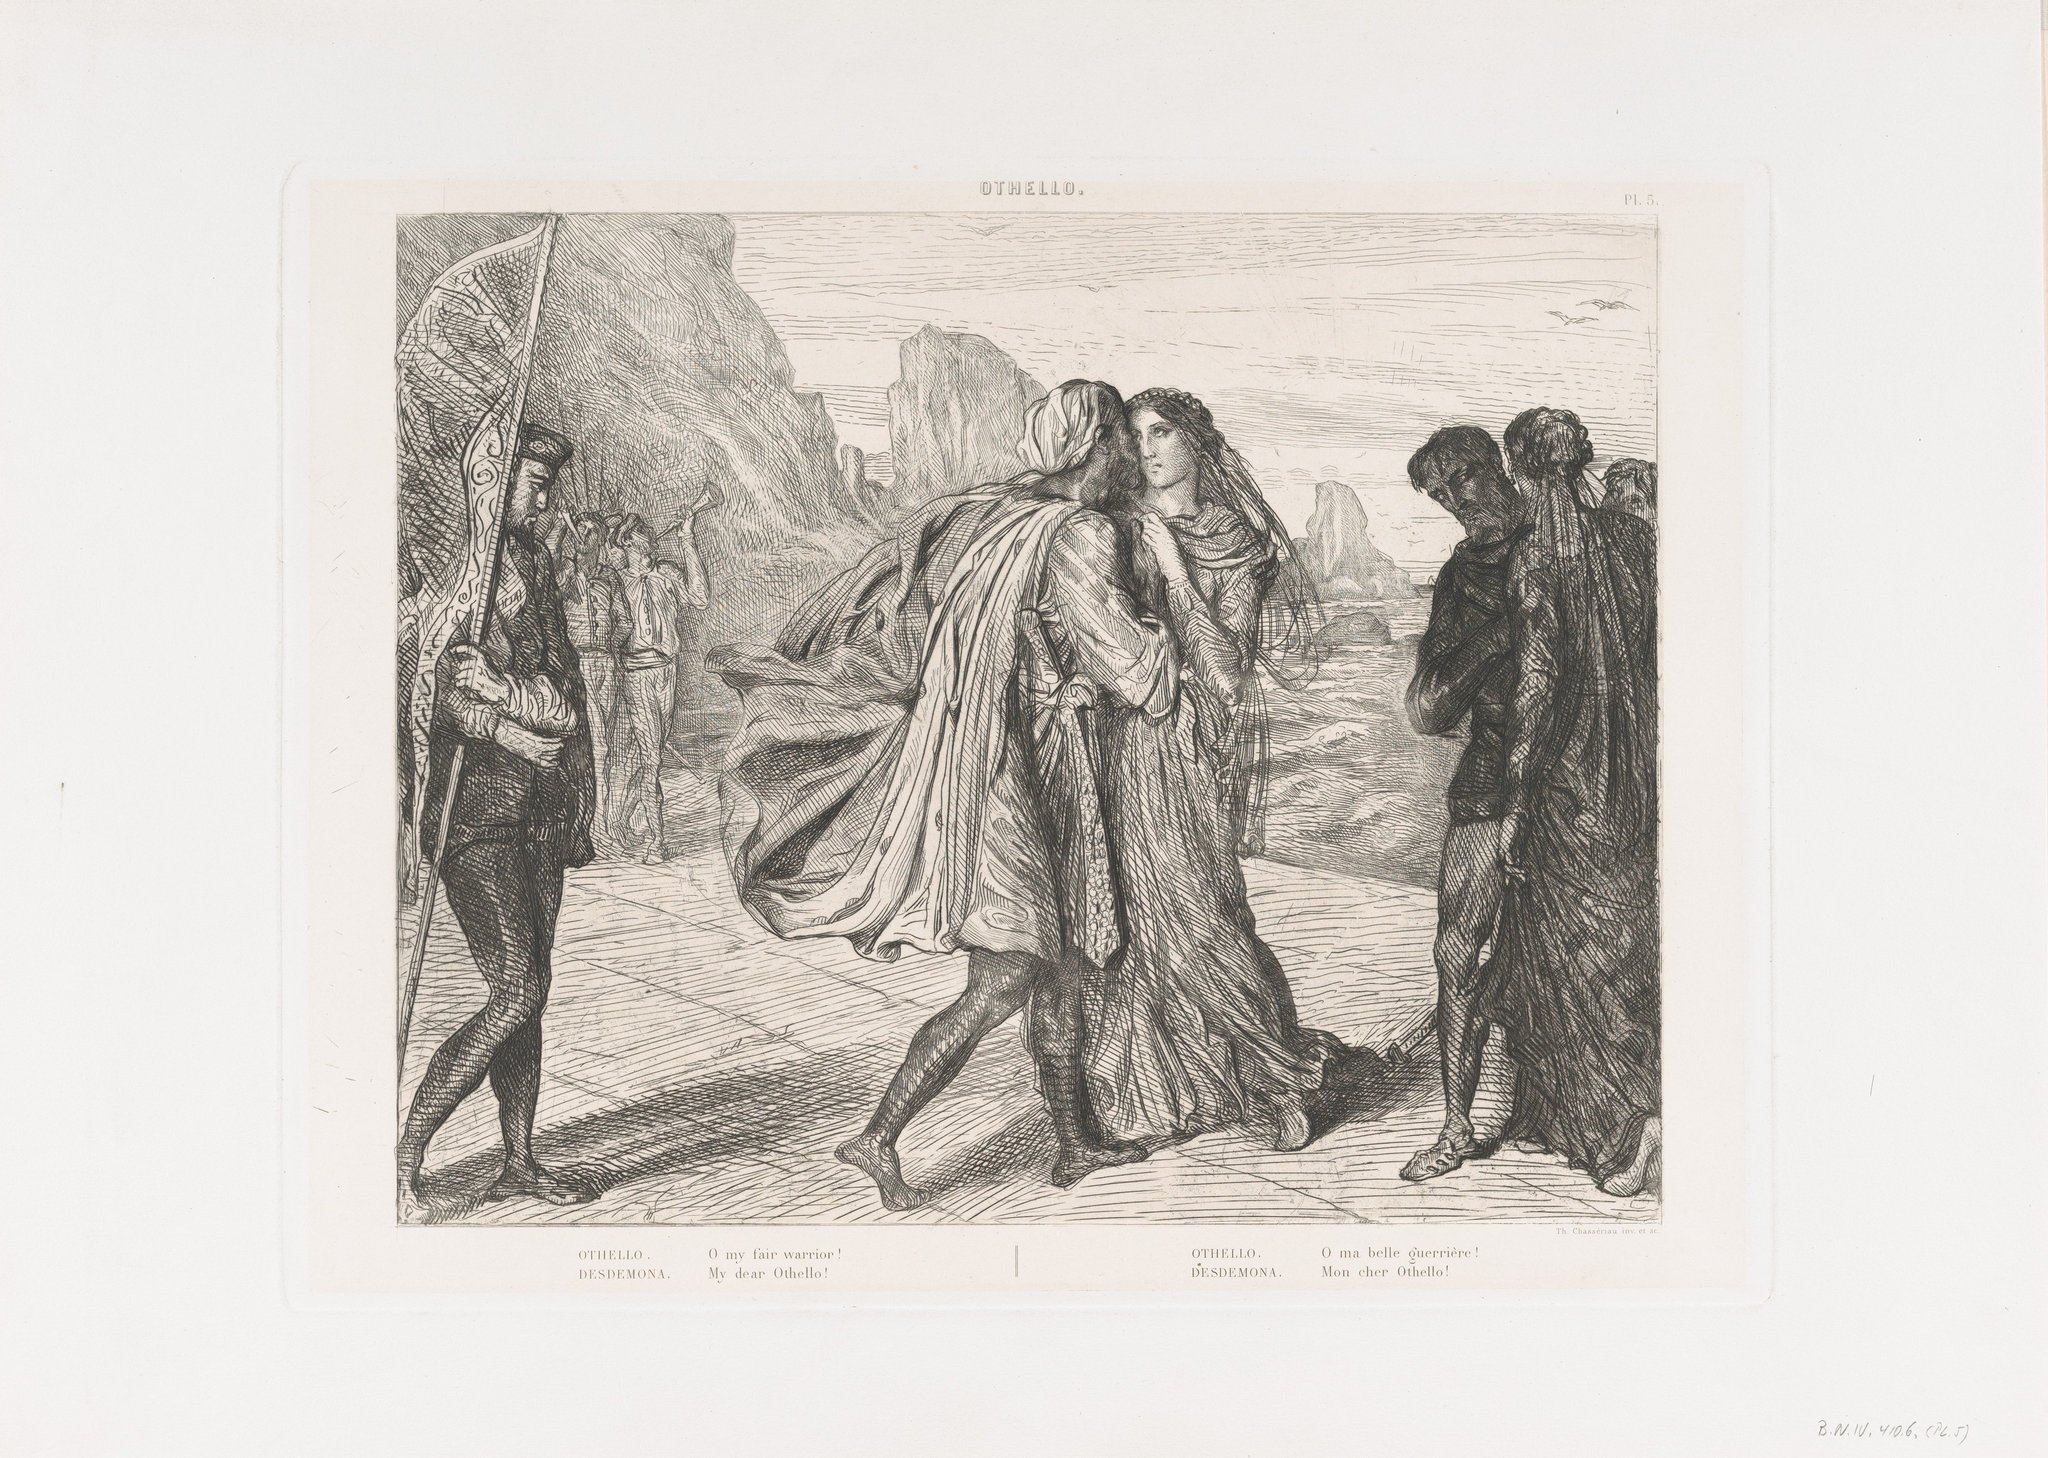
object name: print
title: "O my fair warrior!": plate 5 from Othello (Act 2, Scene 1)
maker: théodore chassériau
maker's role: artist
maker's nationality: french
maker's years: 1819-1856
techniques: printmaking, drypoint, engraving, etching, roulette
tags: shakespeare,men,women